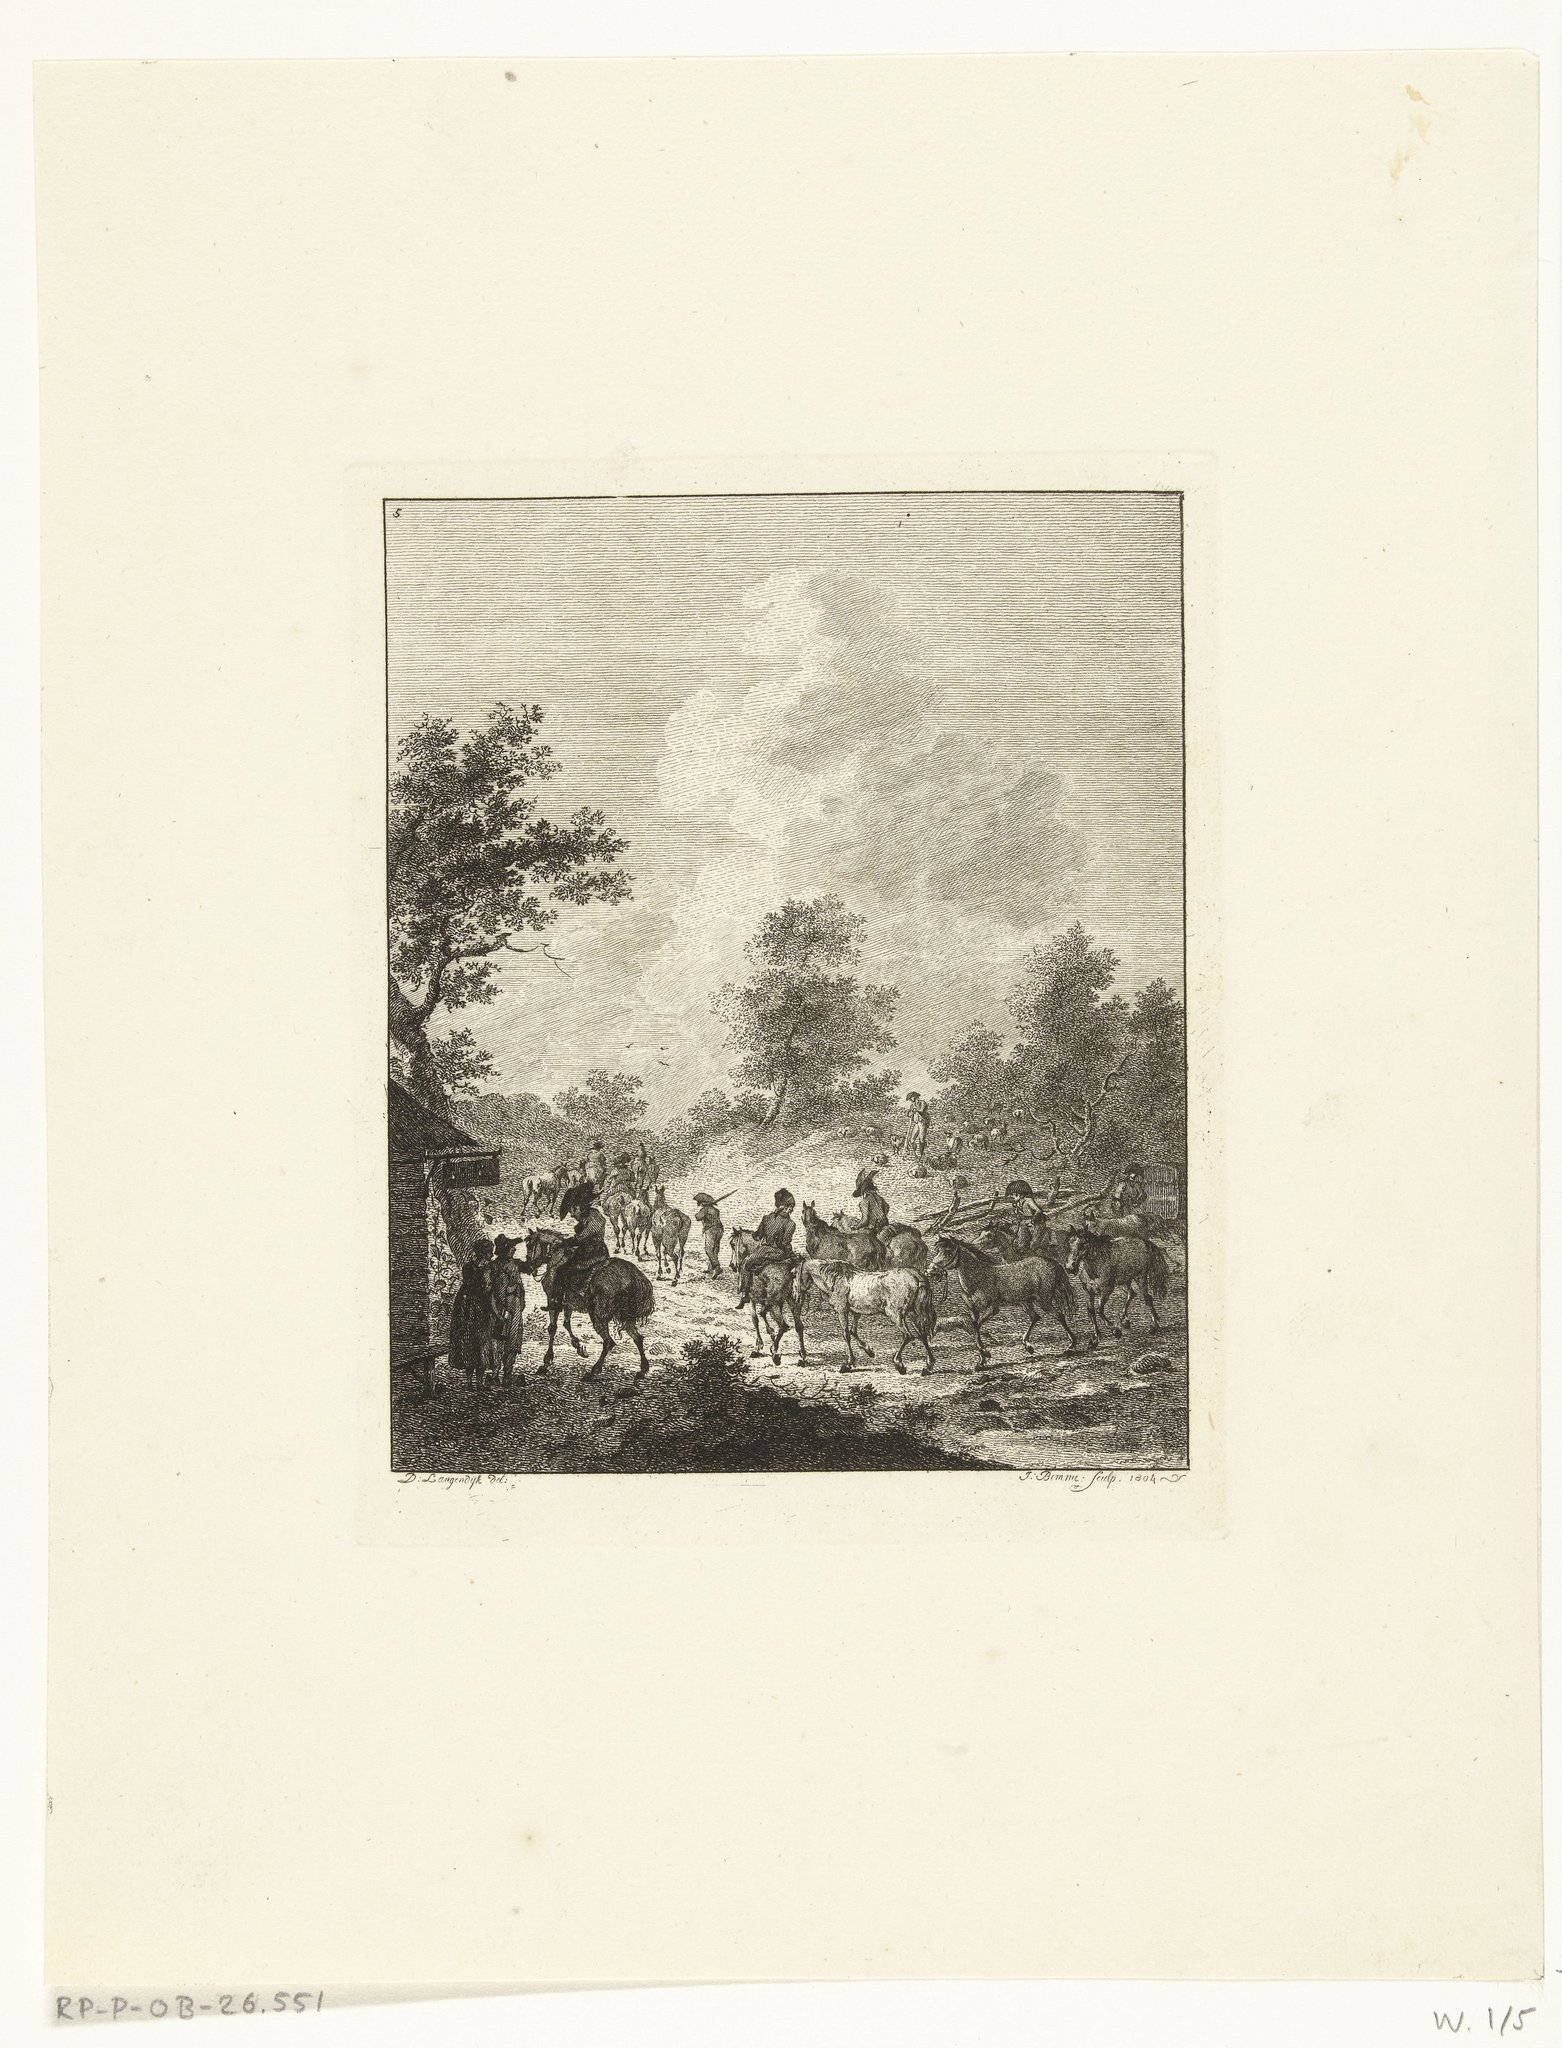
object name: print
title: Een groep cavaleriepaarden bij een herberg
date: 1804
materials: paper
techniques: etching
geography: netherlands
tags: warfare; military affairs (+ cavalry, horsemen)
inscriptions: date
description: Een groep soldaten te paard met een aantal extra cavaleriepaarden bij een herberg. Op de achtergrond een herder met schapen.